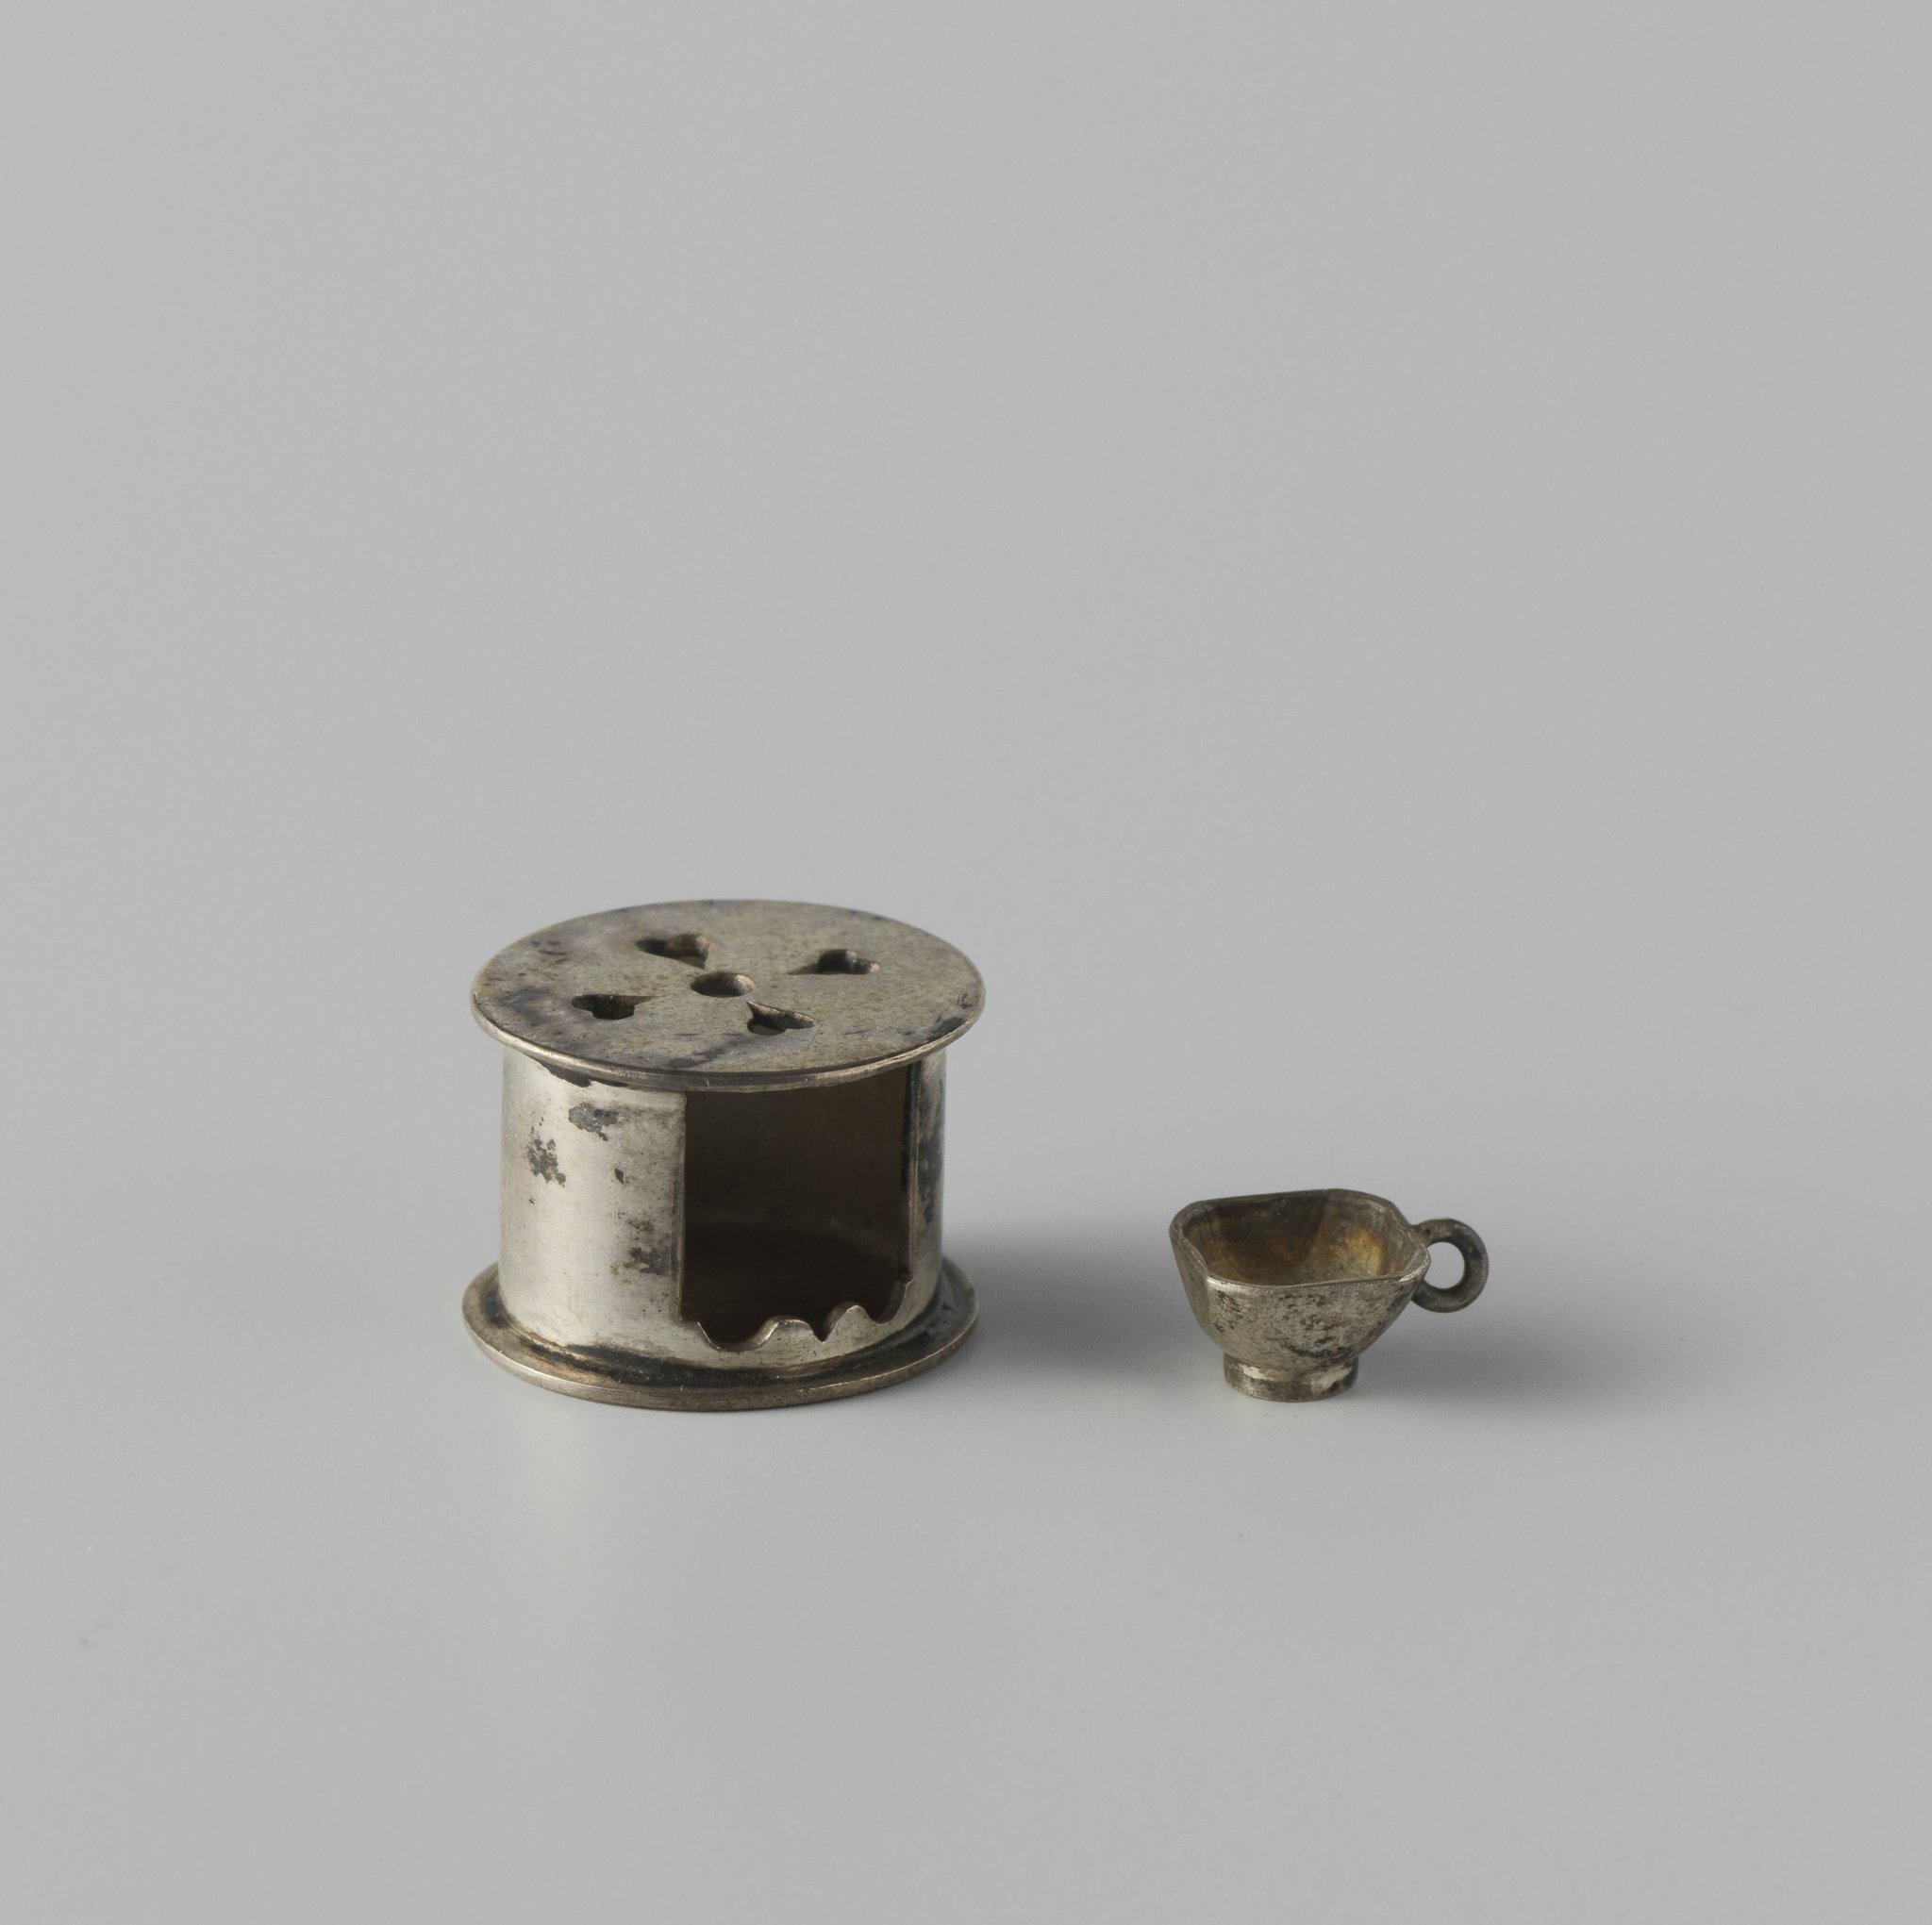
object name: miniature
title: Stoof met uitgezaagde harten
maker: Anonymous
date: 1755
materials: silver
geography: amsterdam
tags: foot-stove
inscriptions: maker's mark: ‘voet 430’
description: Ovale stoof met test. In de bovenkant van de stoof is in het midden een rond gat uitgezaagd en daar omheen vier opengezaagde harten. In de stoof staat een test op een voet en met een oor. De stoof is gemerkt: mt.= Voet 430. De stoof is gelijk aan vijf stoven met de invnrs. BK-NM-11177-175, BK-NM-11177-176, BK-NM-11177-178, BK-NM-11177-179, BK-NM-11177-180.